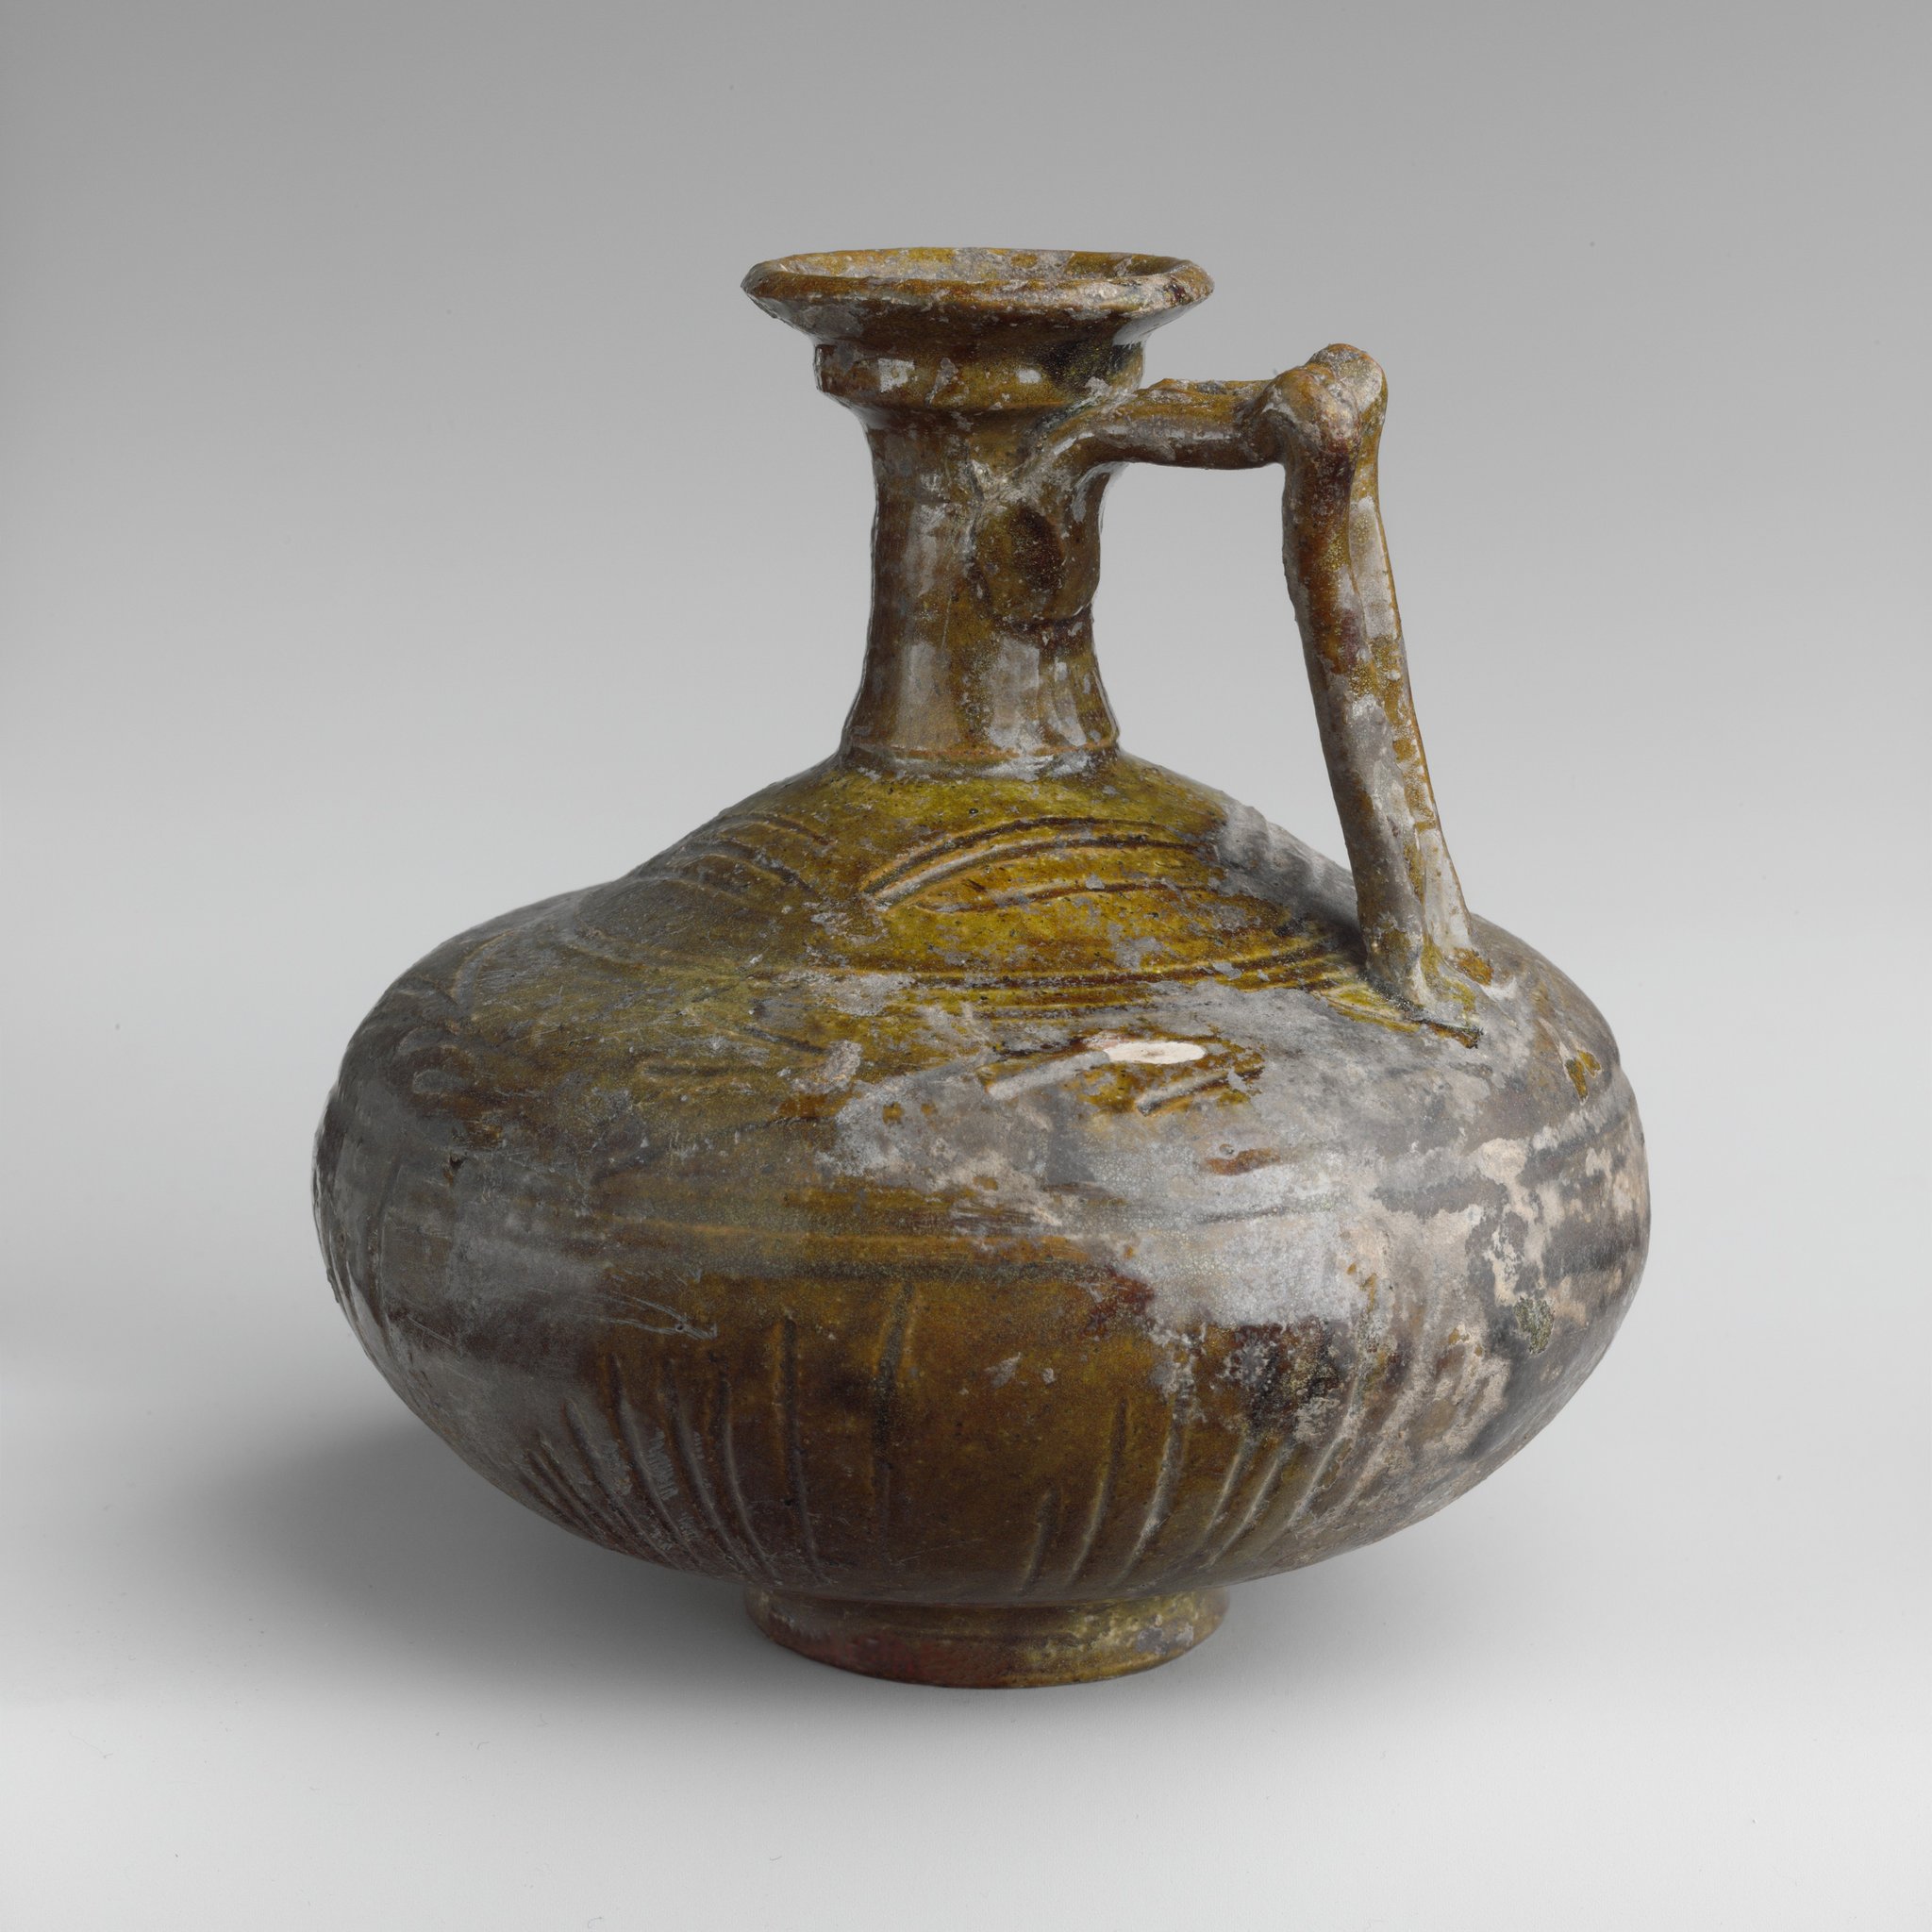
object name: jug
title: Terracotta jug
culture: roman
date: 67-200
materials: terracotta